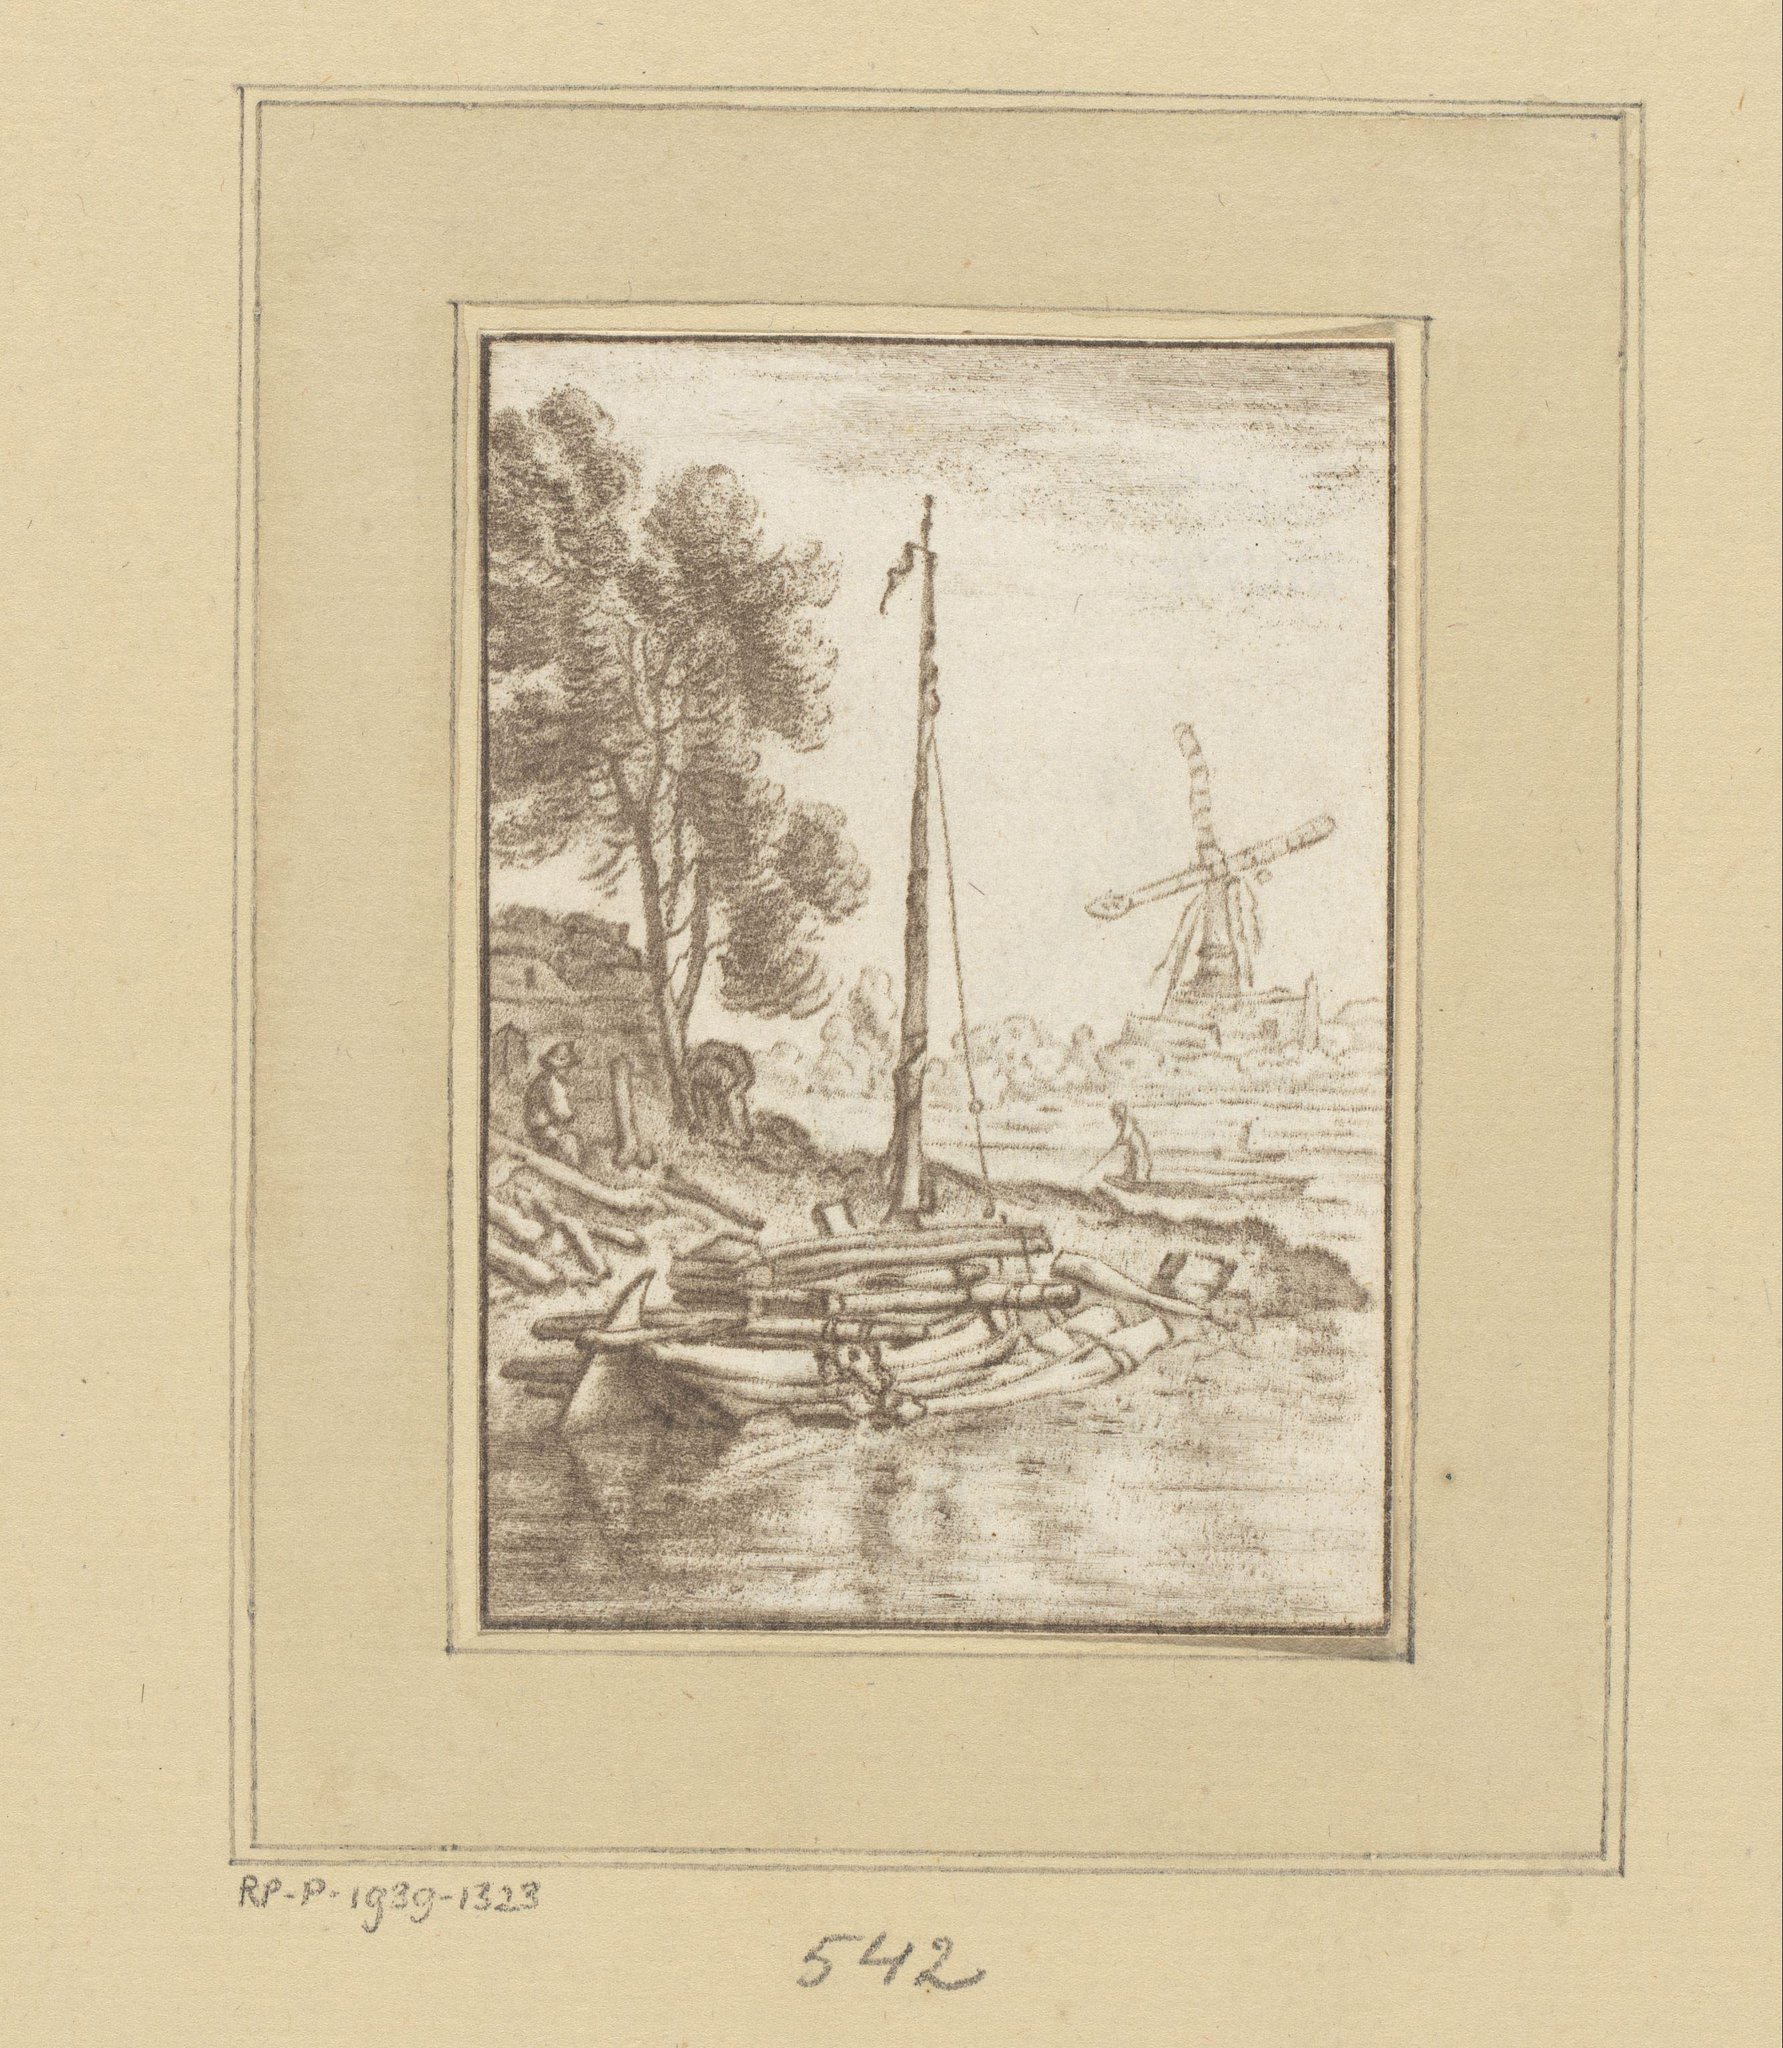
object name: print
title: Bochtige rivier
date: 1761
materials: paper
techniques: printmaking, etching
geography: amsterdam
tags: river, shipyard, shipdock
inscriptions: collector's mark: ‘RIJKS / MUSM’, inscription: ‘H. Zaftleven. del. Ploos v. Amstel Fecit.’, collector's mark: Lugt 2725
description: De bocht van een rivier met links een scheepswerf en aan de overzijde een molen. De prent ligt los in een album, zie blad 3.